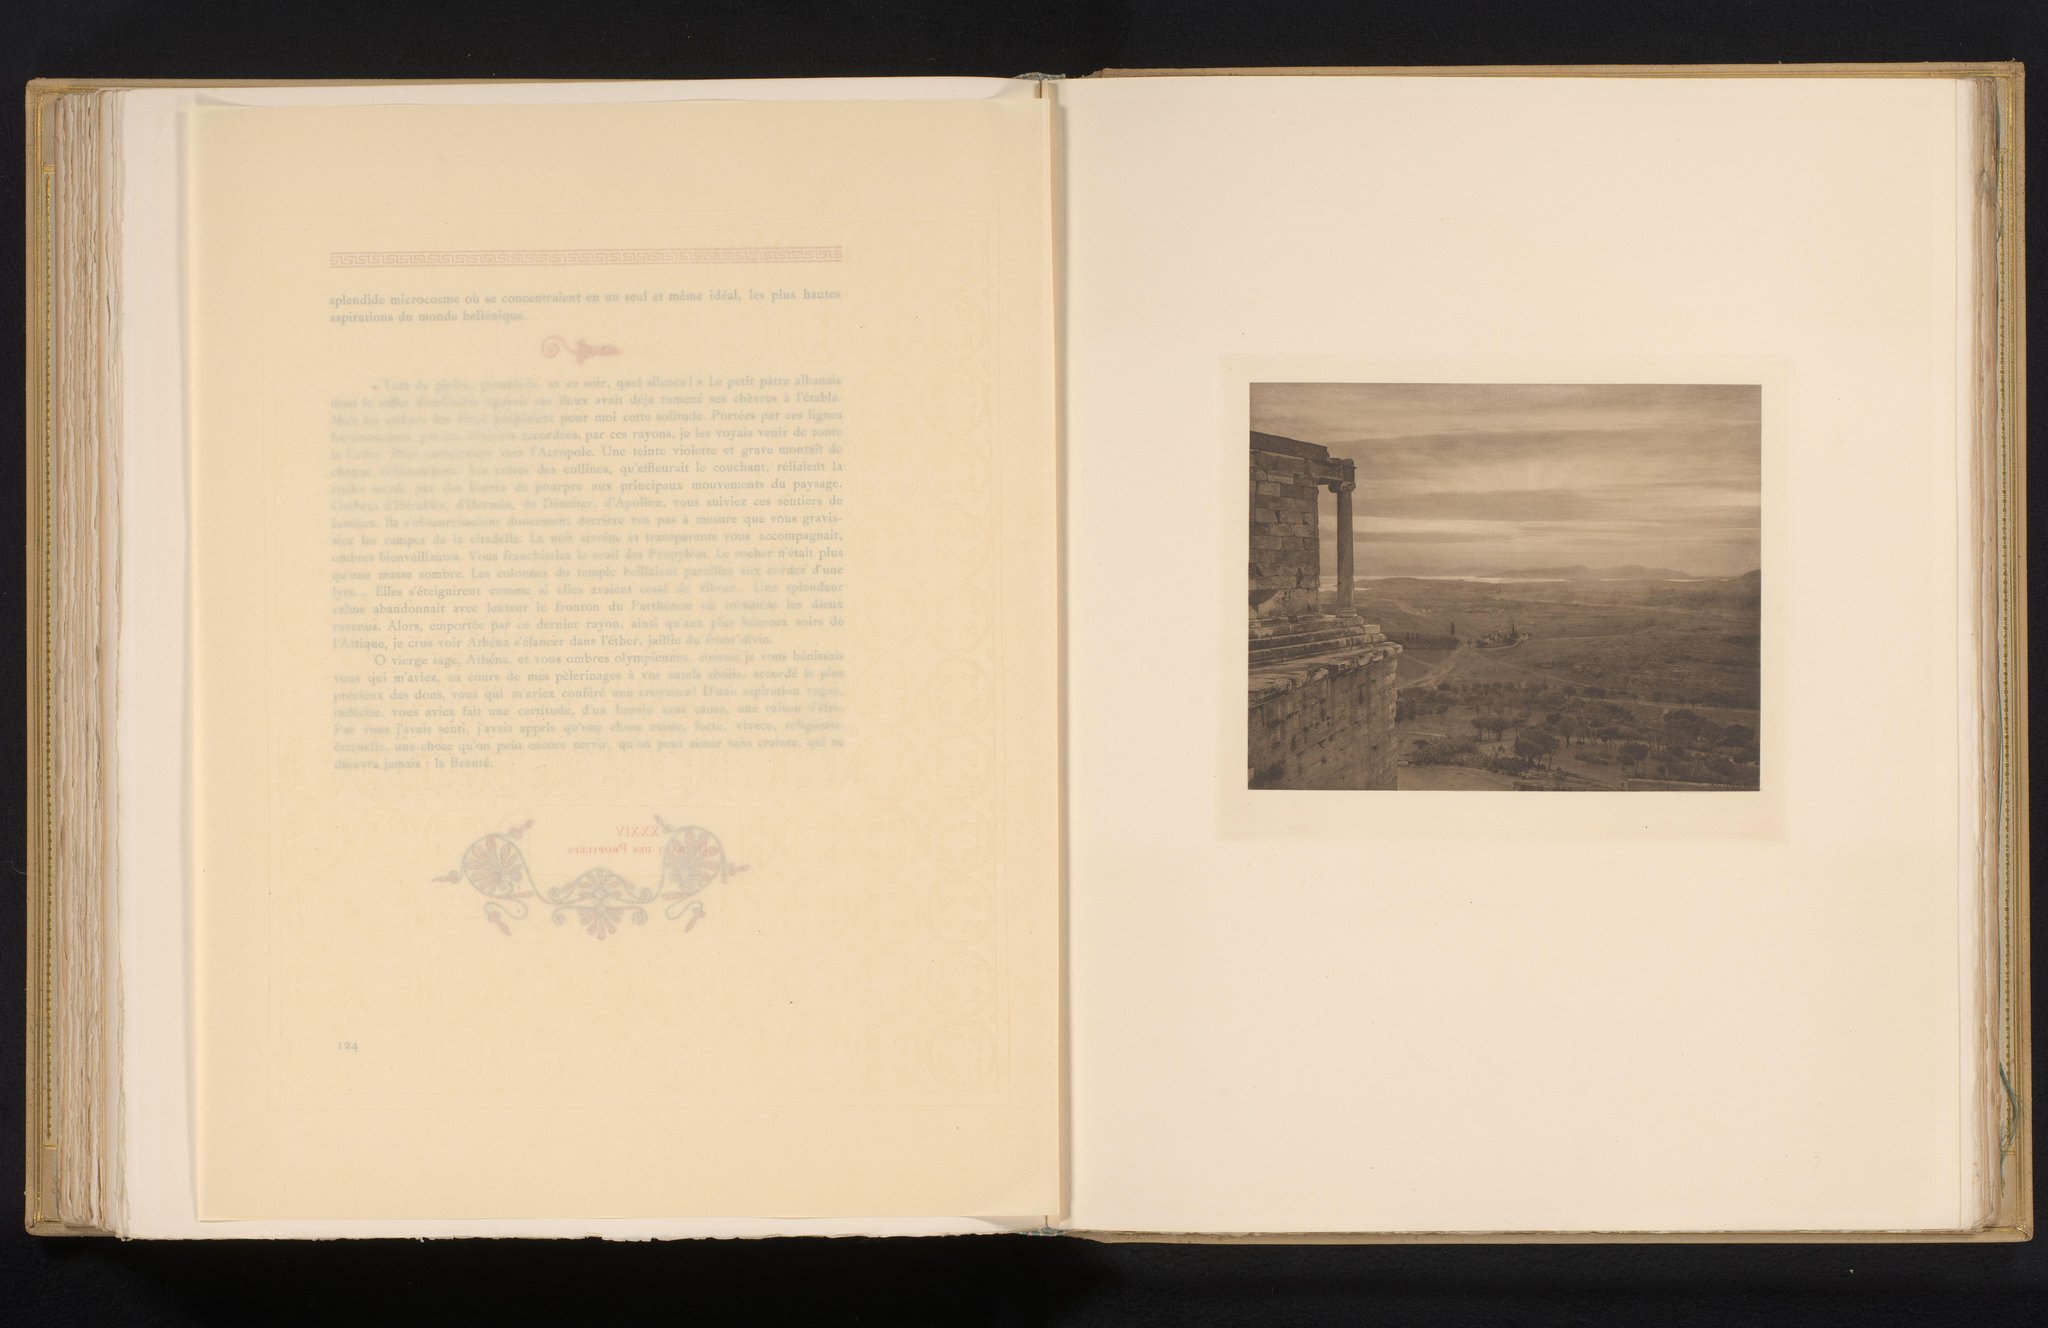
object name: page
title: Uitzicht vanaf de Propyleeën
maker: frédéric boissonnas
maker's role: fotograaf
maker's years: 1858-1946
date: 1905-1910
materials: paper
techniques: photoaquatint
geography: berlin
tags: temple, shrine ~ greek religion